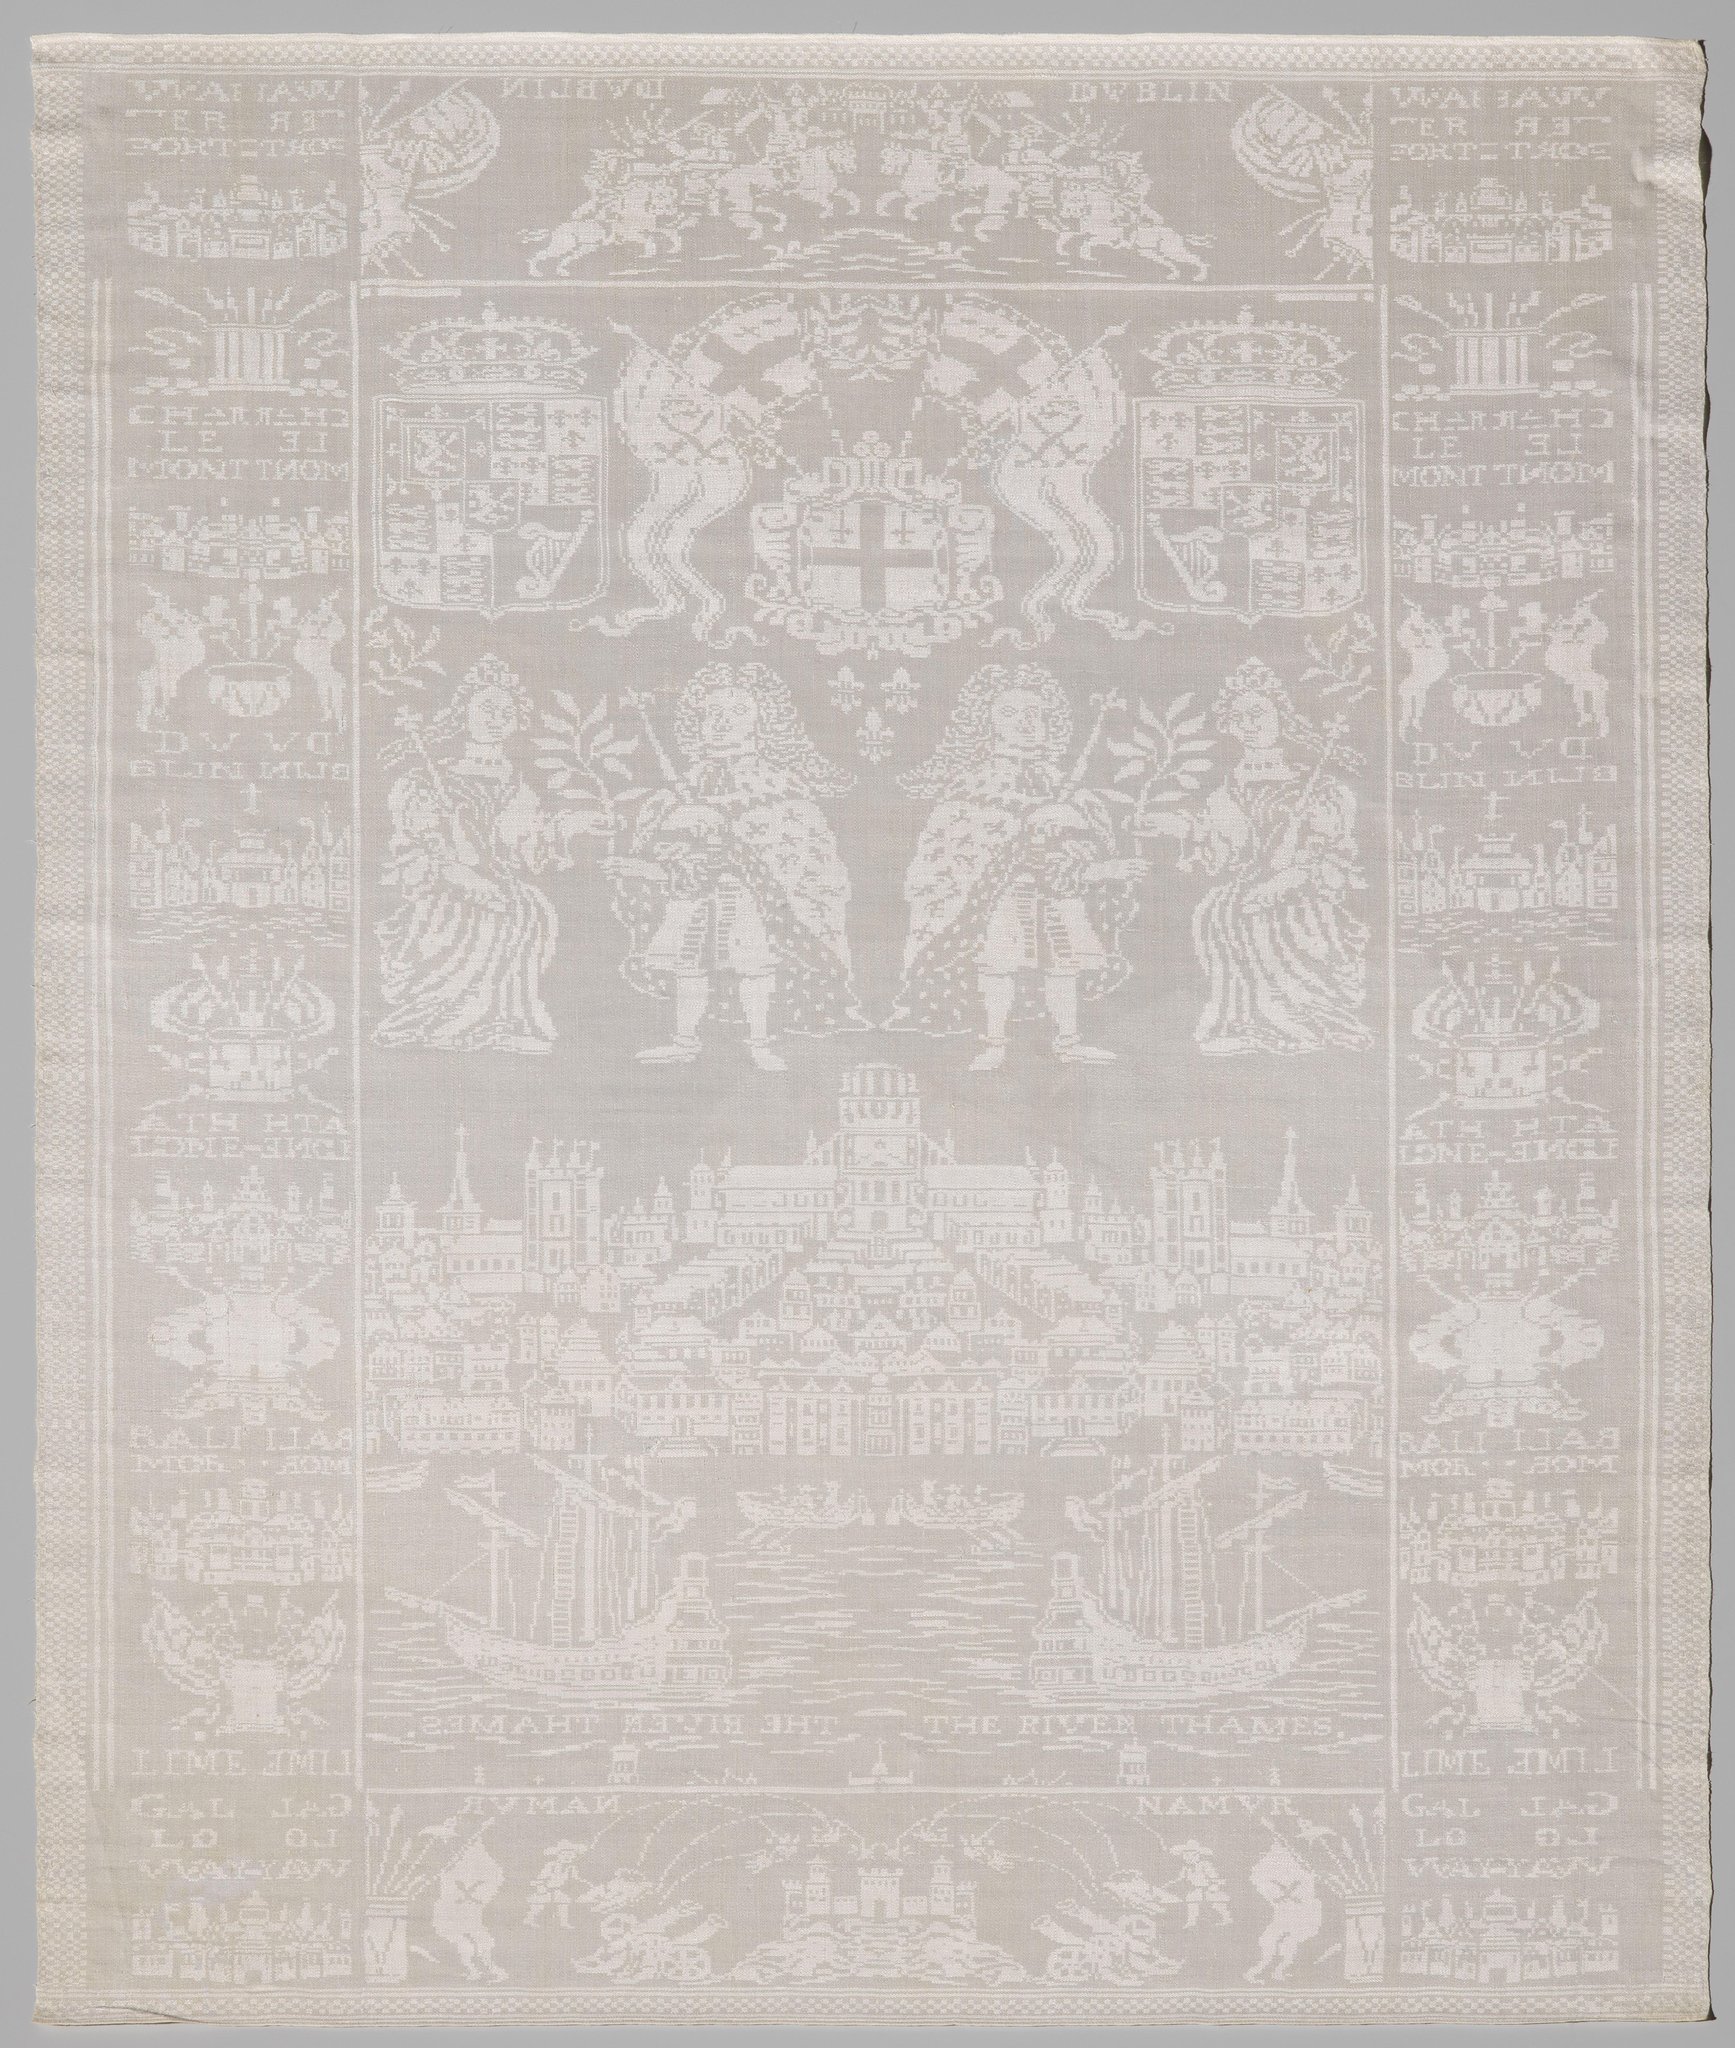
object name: napkin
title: Servet met London, de Thames, Engelse wapens, koning Willem III en Mary Stuart en veroverde steden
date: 1695-1699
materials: linen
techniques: damask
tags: the hague, william iii (prince of orange and king of england, scotland, and ireland), maria ii stuart (koningin van engeland, schotland en ierland), london